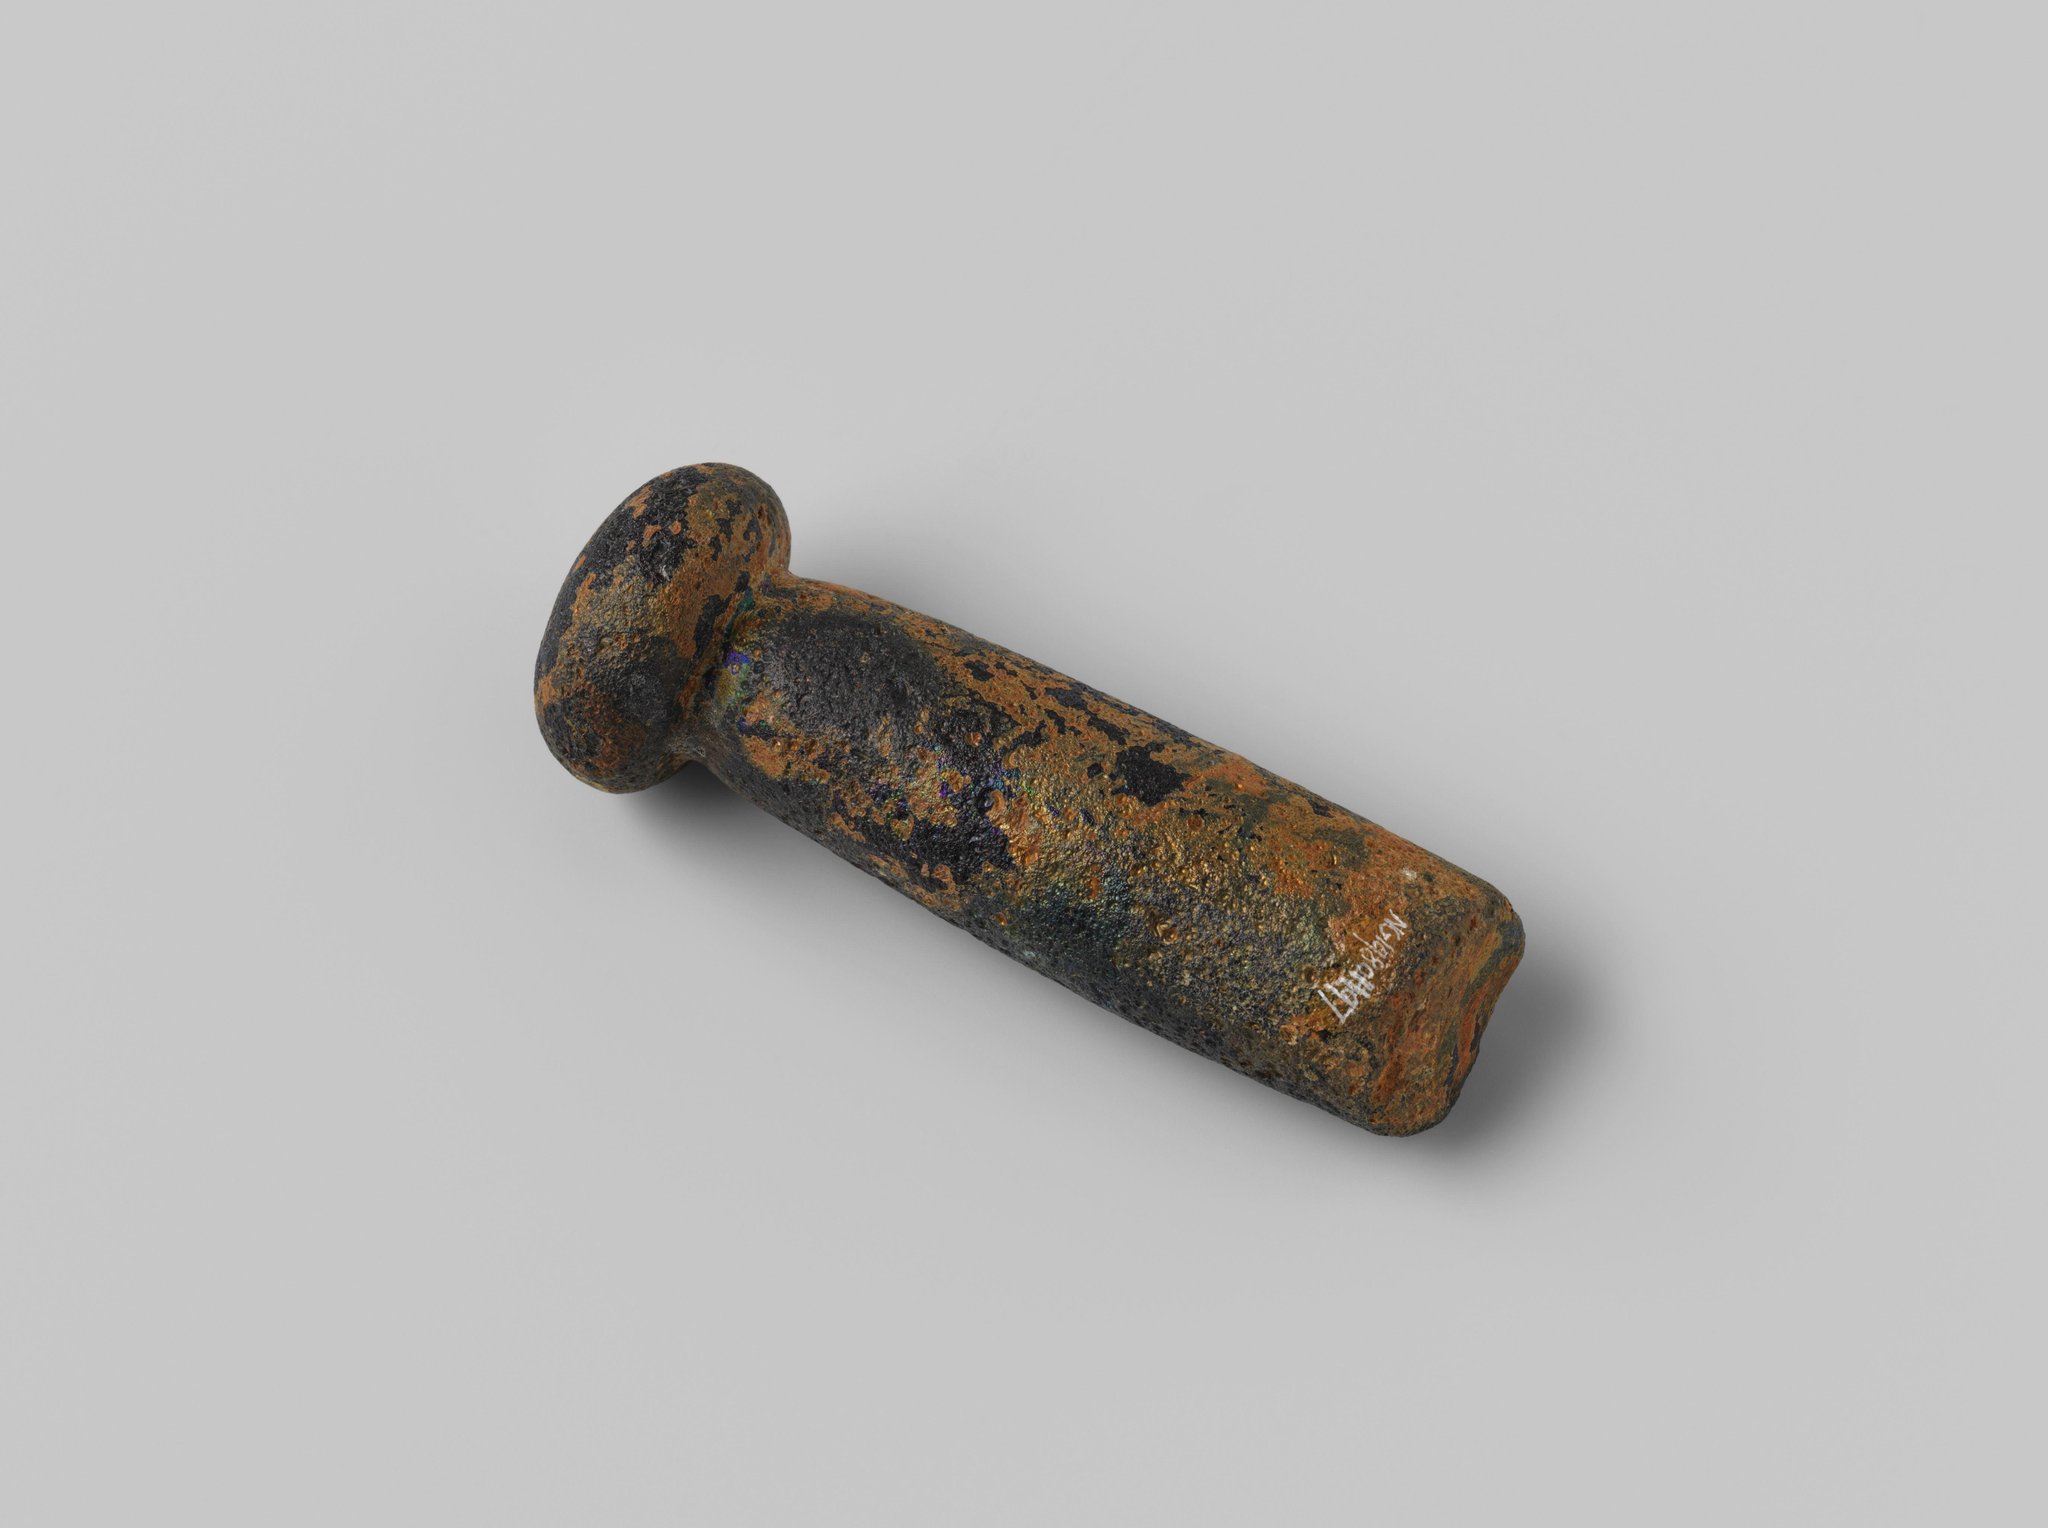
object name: beater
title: Stamper uit het wrak van de Oost-Indiëvaarder Hollandia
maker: Anonymous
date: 1700-1743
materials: glass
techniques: green glass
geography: netherlands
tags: verenigde oostindische compagnie, hollandia (schip), annet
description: Tools and instruments, grinding and scharpening, pestle; fragm, upper end broken: cylindrical, tapering stem, flattened ball-shaped end.